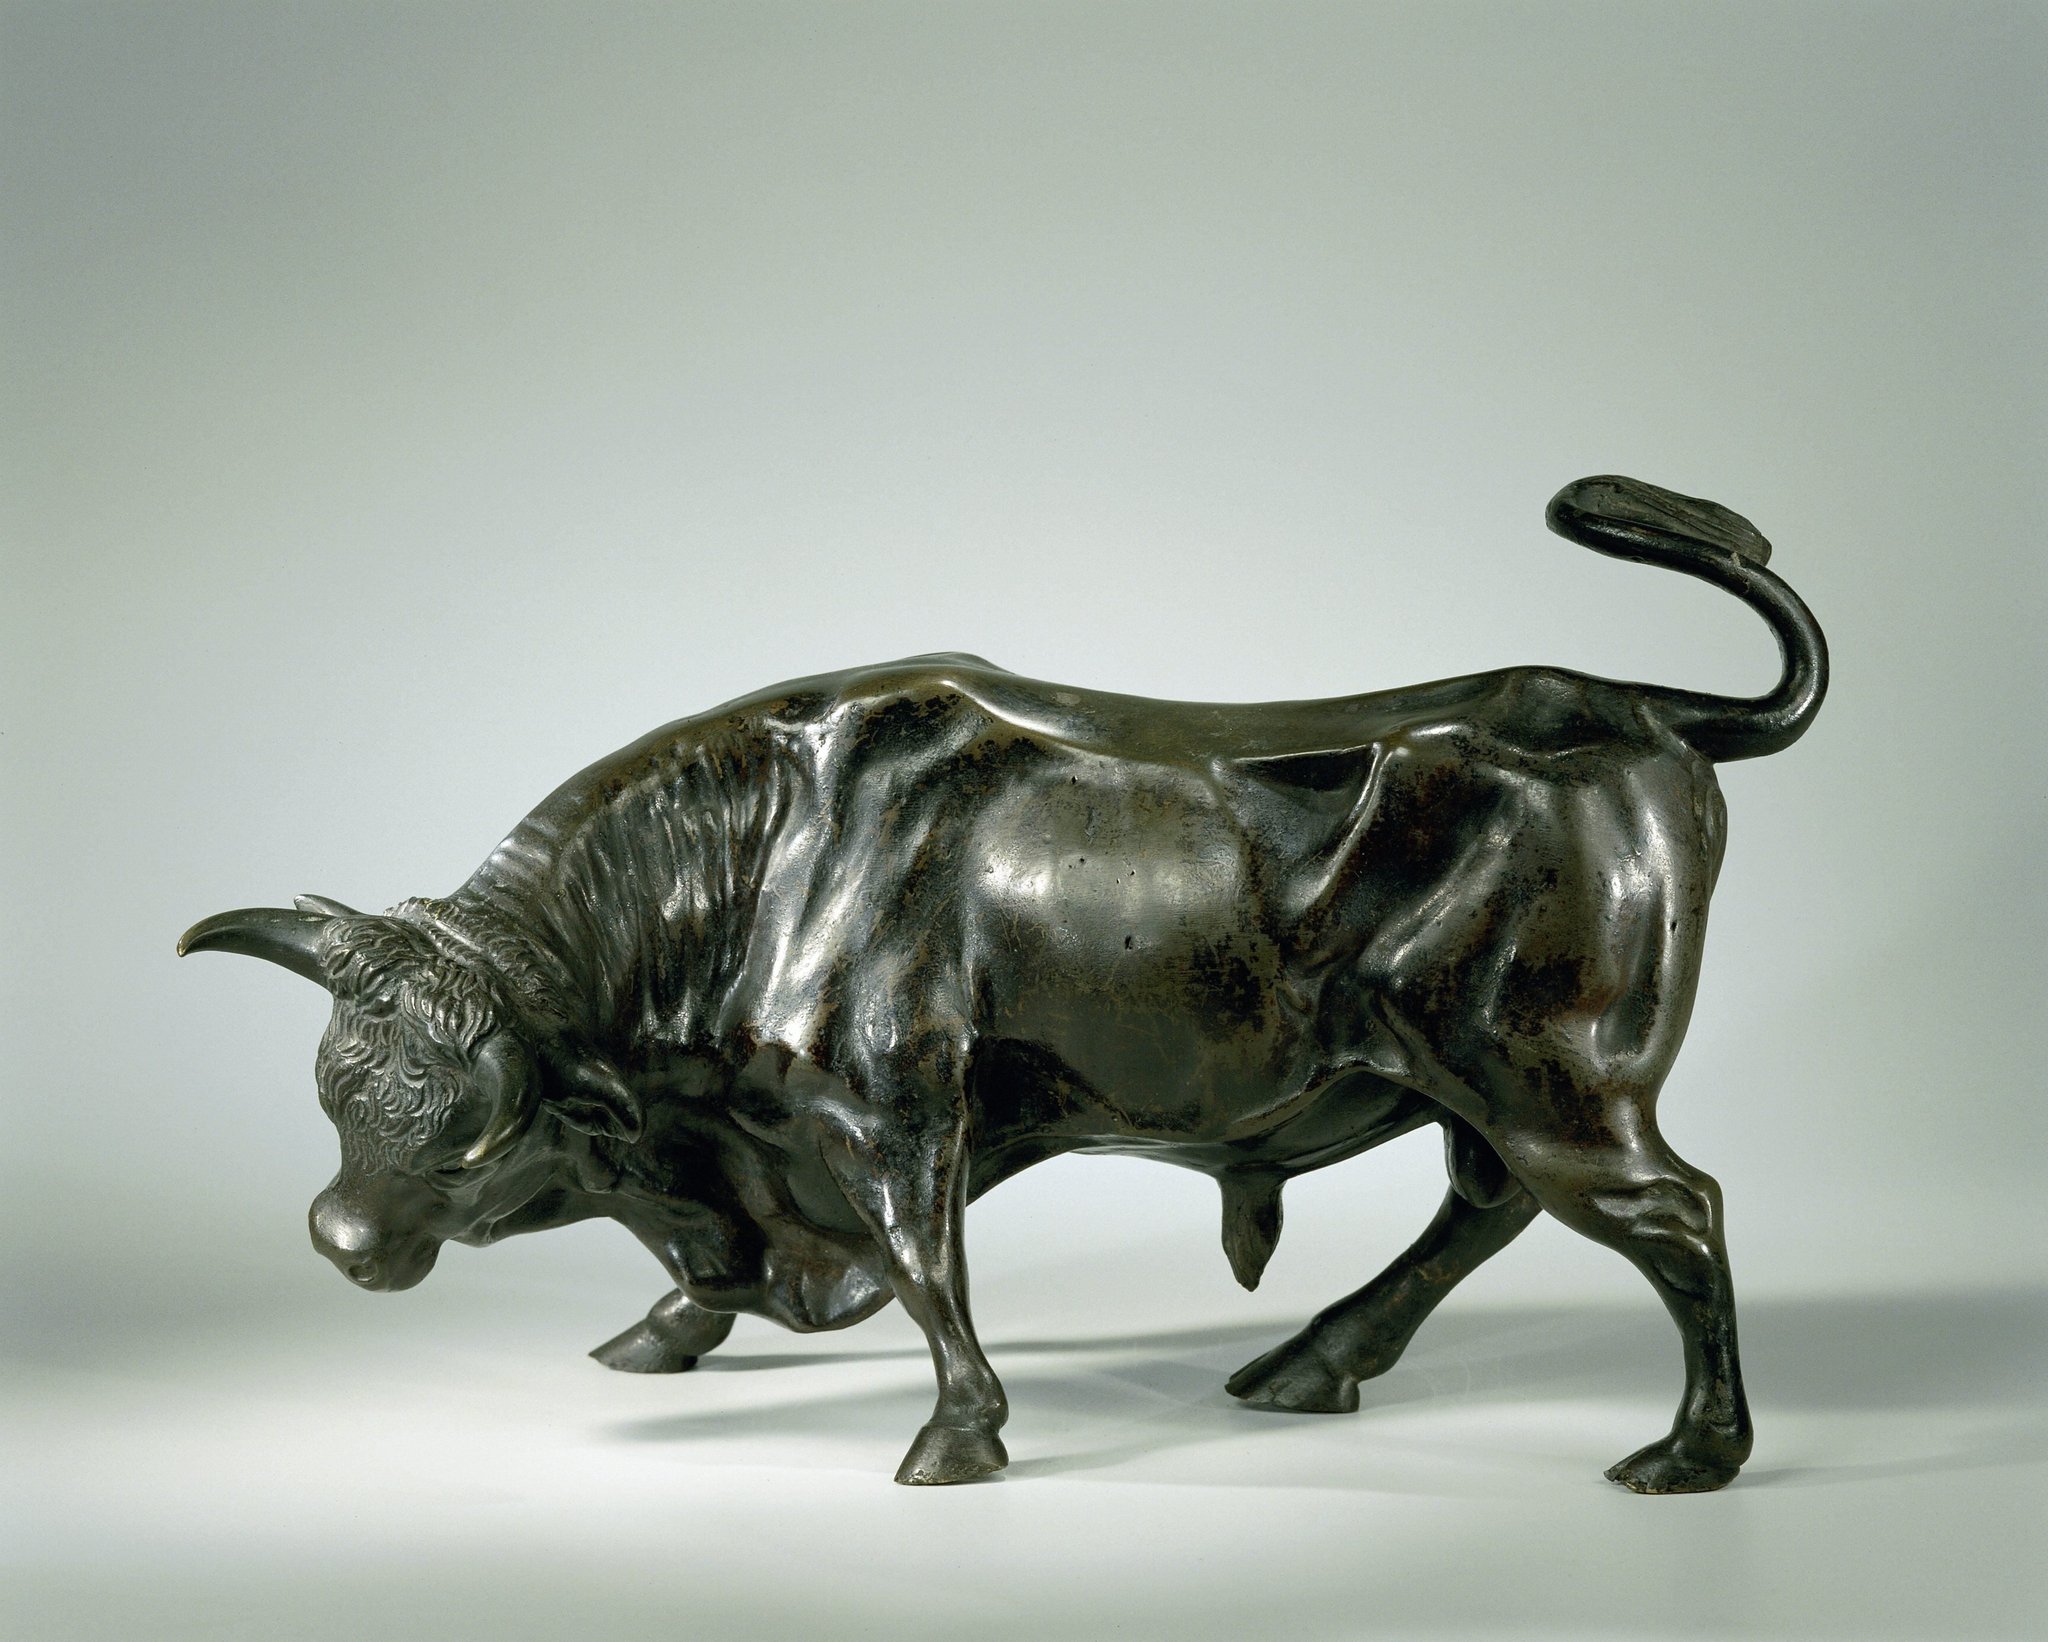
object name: sculpture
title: Charging Bull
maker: Anonymous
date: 1850-1900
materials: bronze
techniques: lacquer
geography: southern netherlands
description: Met de voorpoten gespreid, de staart boven zich uitslaand, stoot hij met de kop naar links.